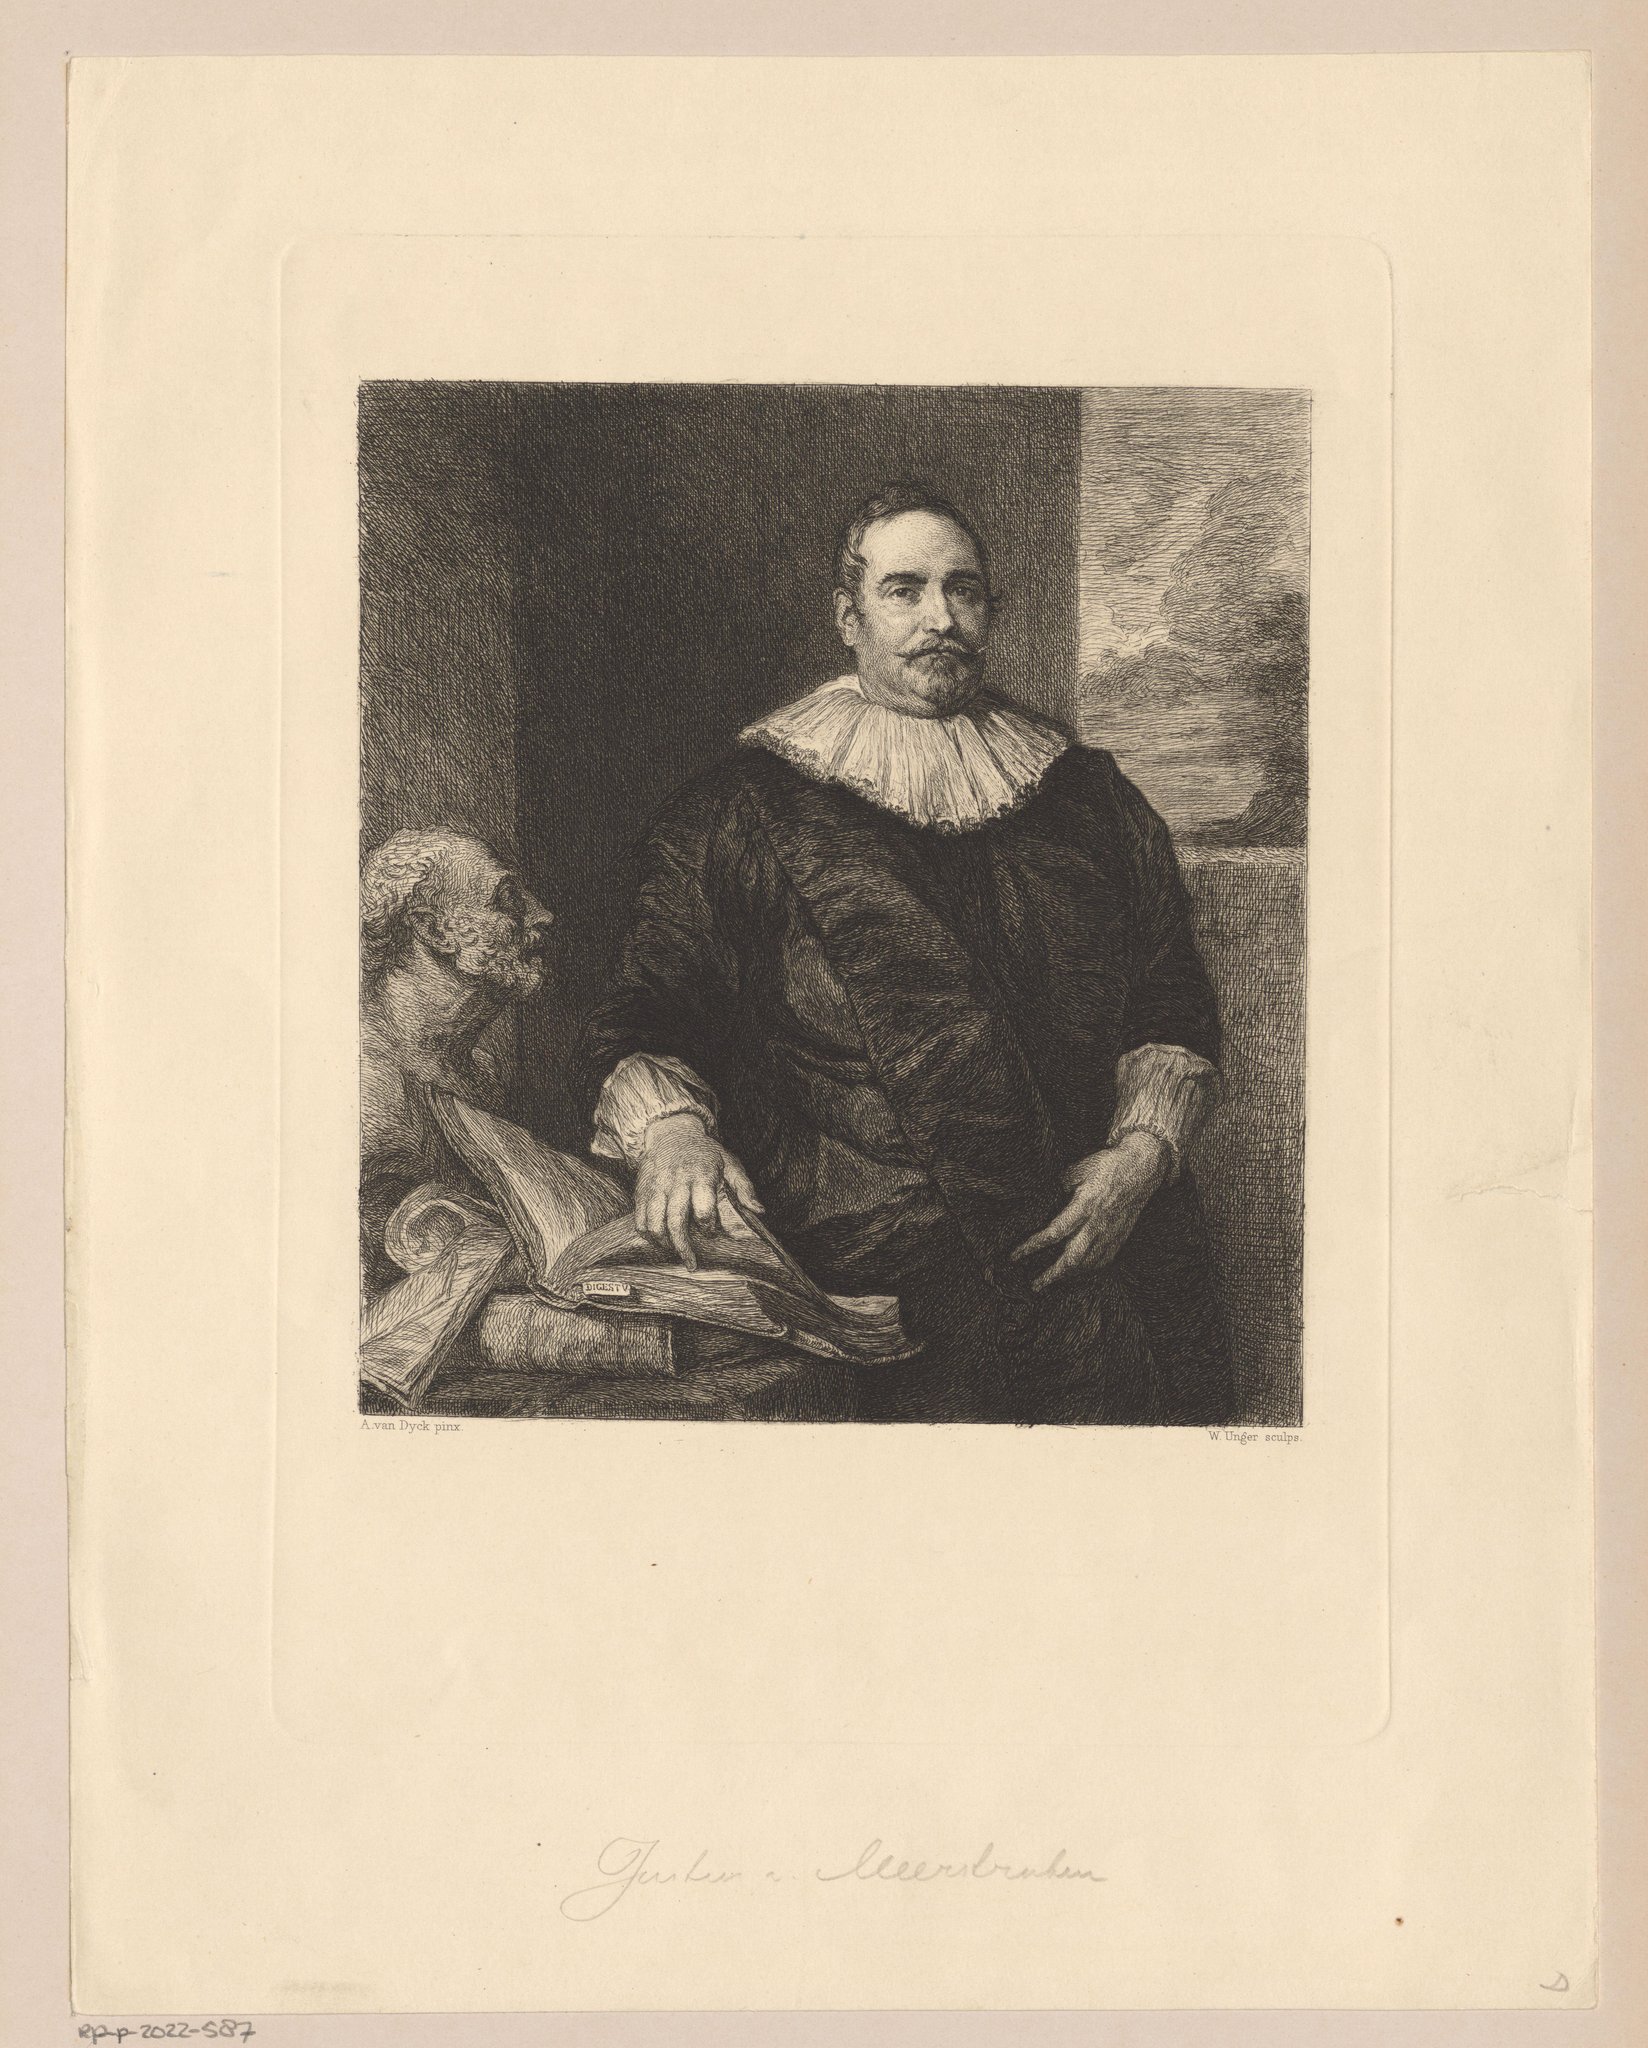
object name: print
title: Portret van Justus van Meerstraten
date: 1847-1889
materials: paper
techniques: etching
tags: historical persons, piece of sculpture, reproduction of a piece of sculpture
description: Prent naar het schilderij door Anthony van Dyck in de Gemäldegalerie Alte Meister te Kassel (inv.nr. GK 420).